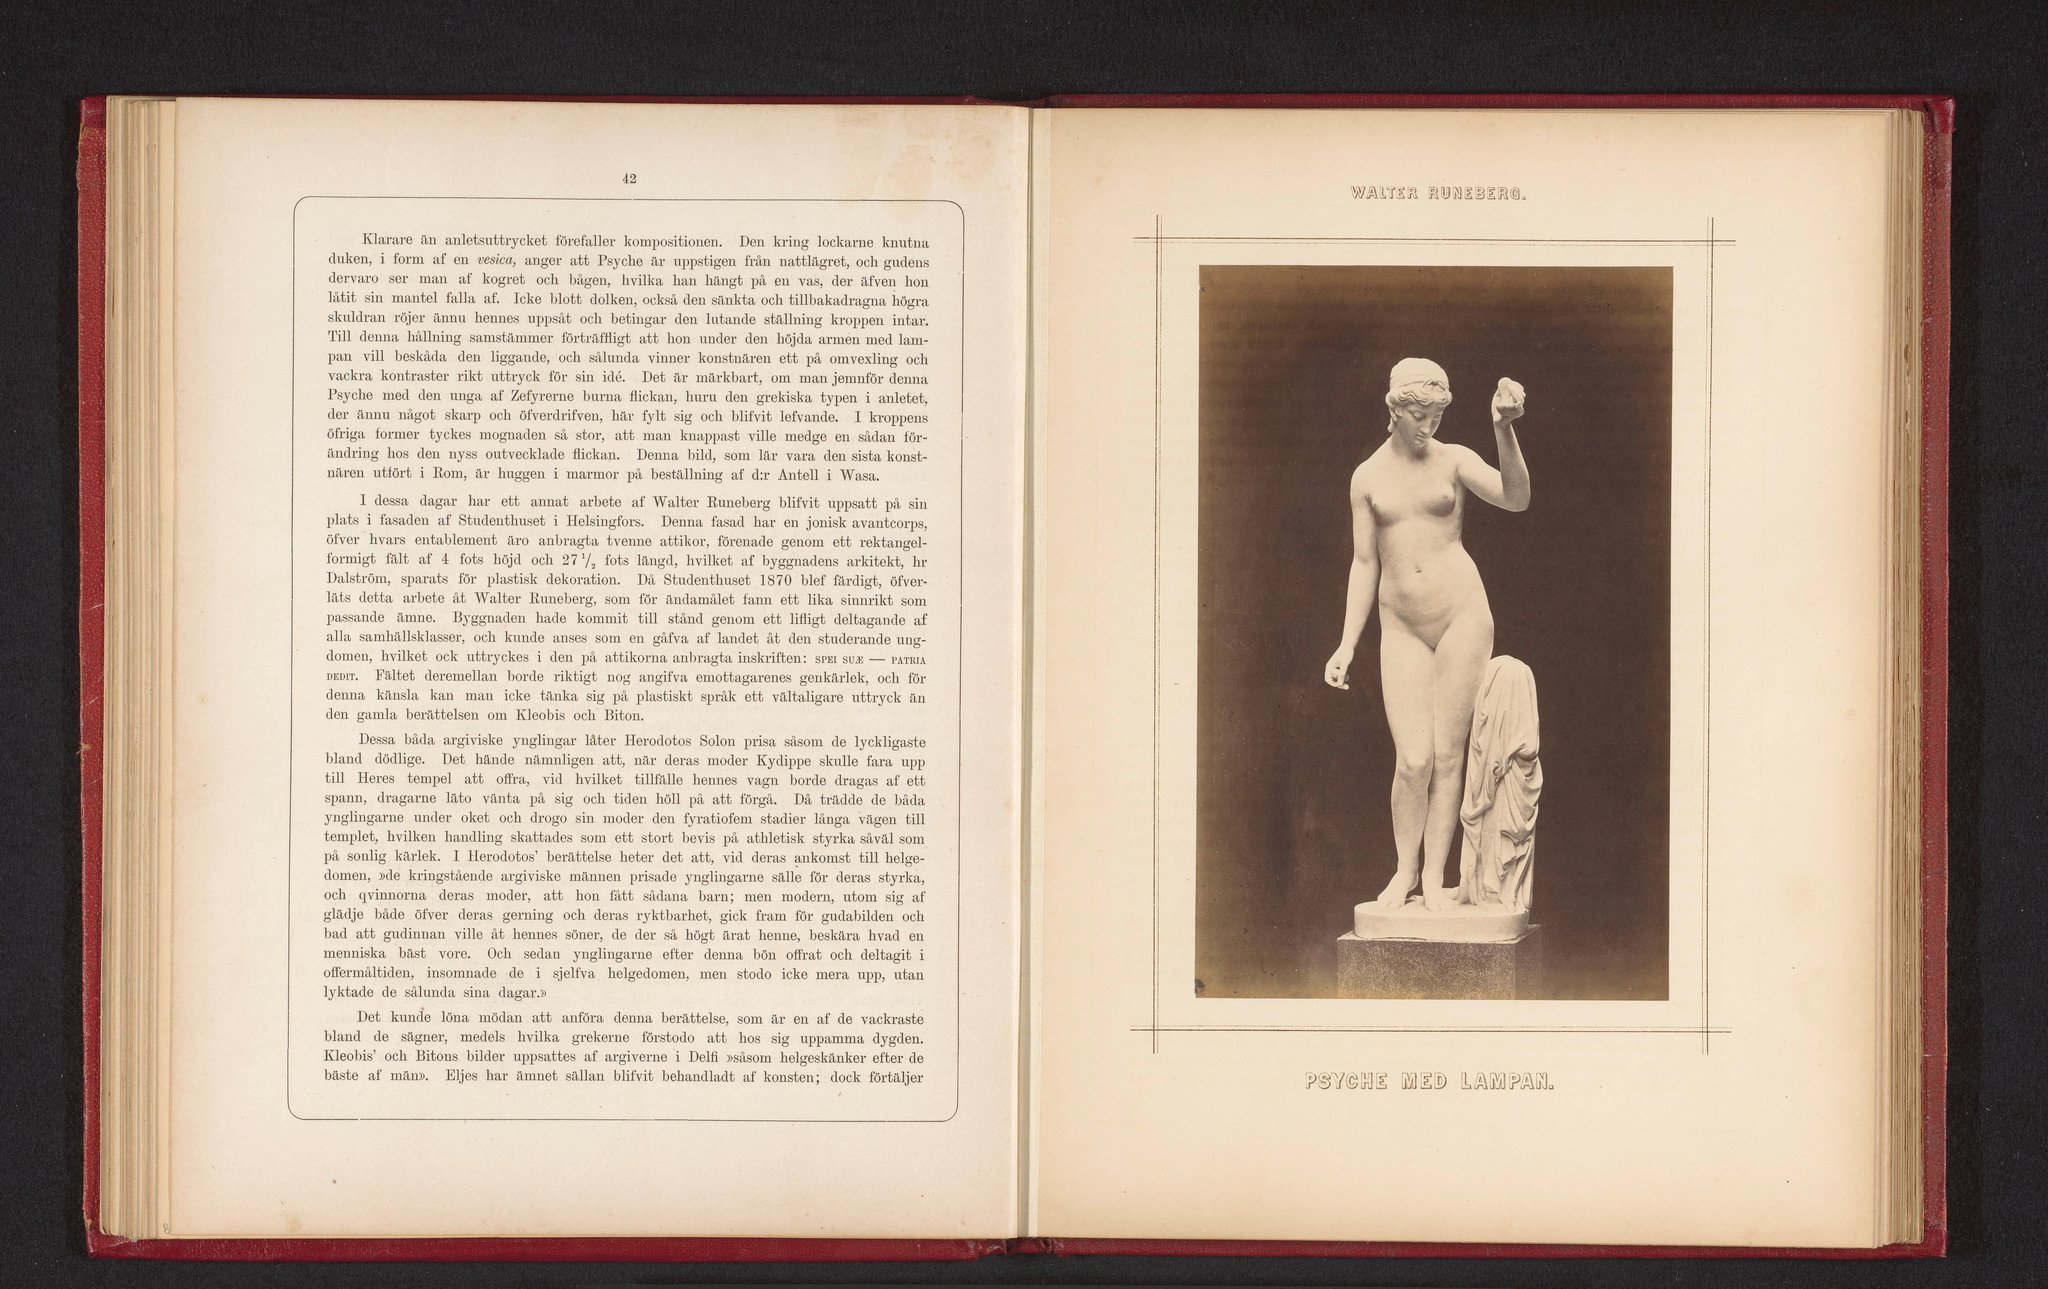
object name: page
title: Sculptuur van Psyche met een lamp door Walter Runeberg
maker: johannes jaeger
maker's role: fotograaf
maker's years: 1832-1908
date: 1874-1879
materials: photographic support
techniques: albumen print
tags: psyche, piece of sculpture, reproduction of a piece of sculpture, lighting; lamps